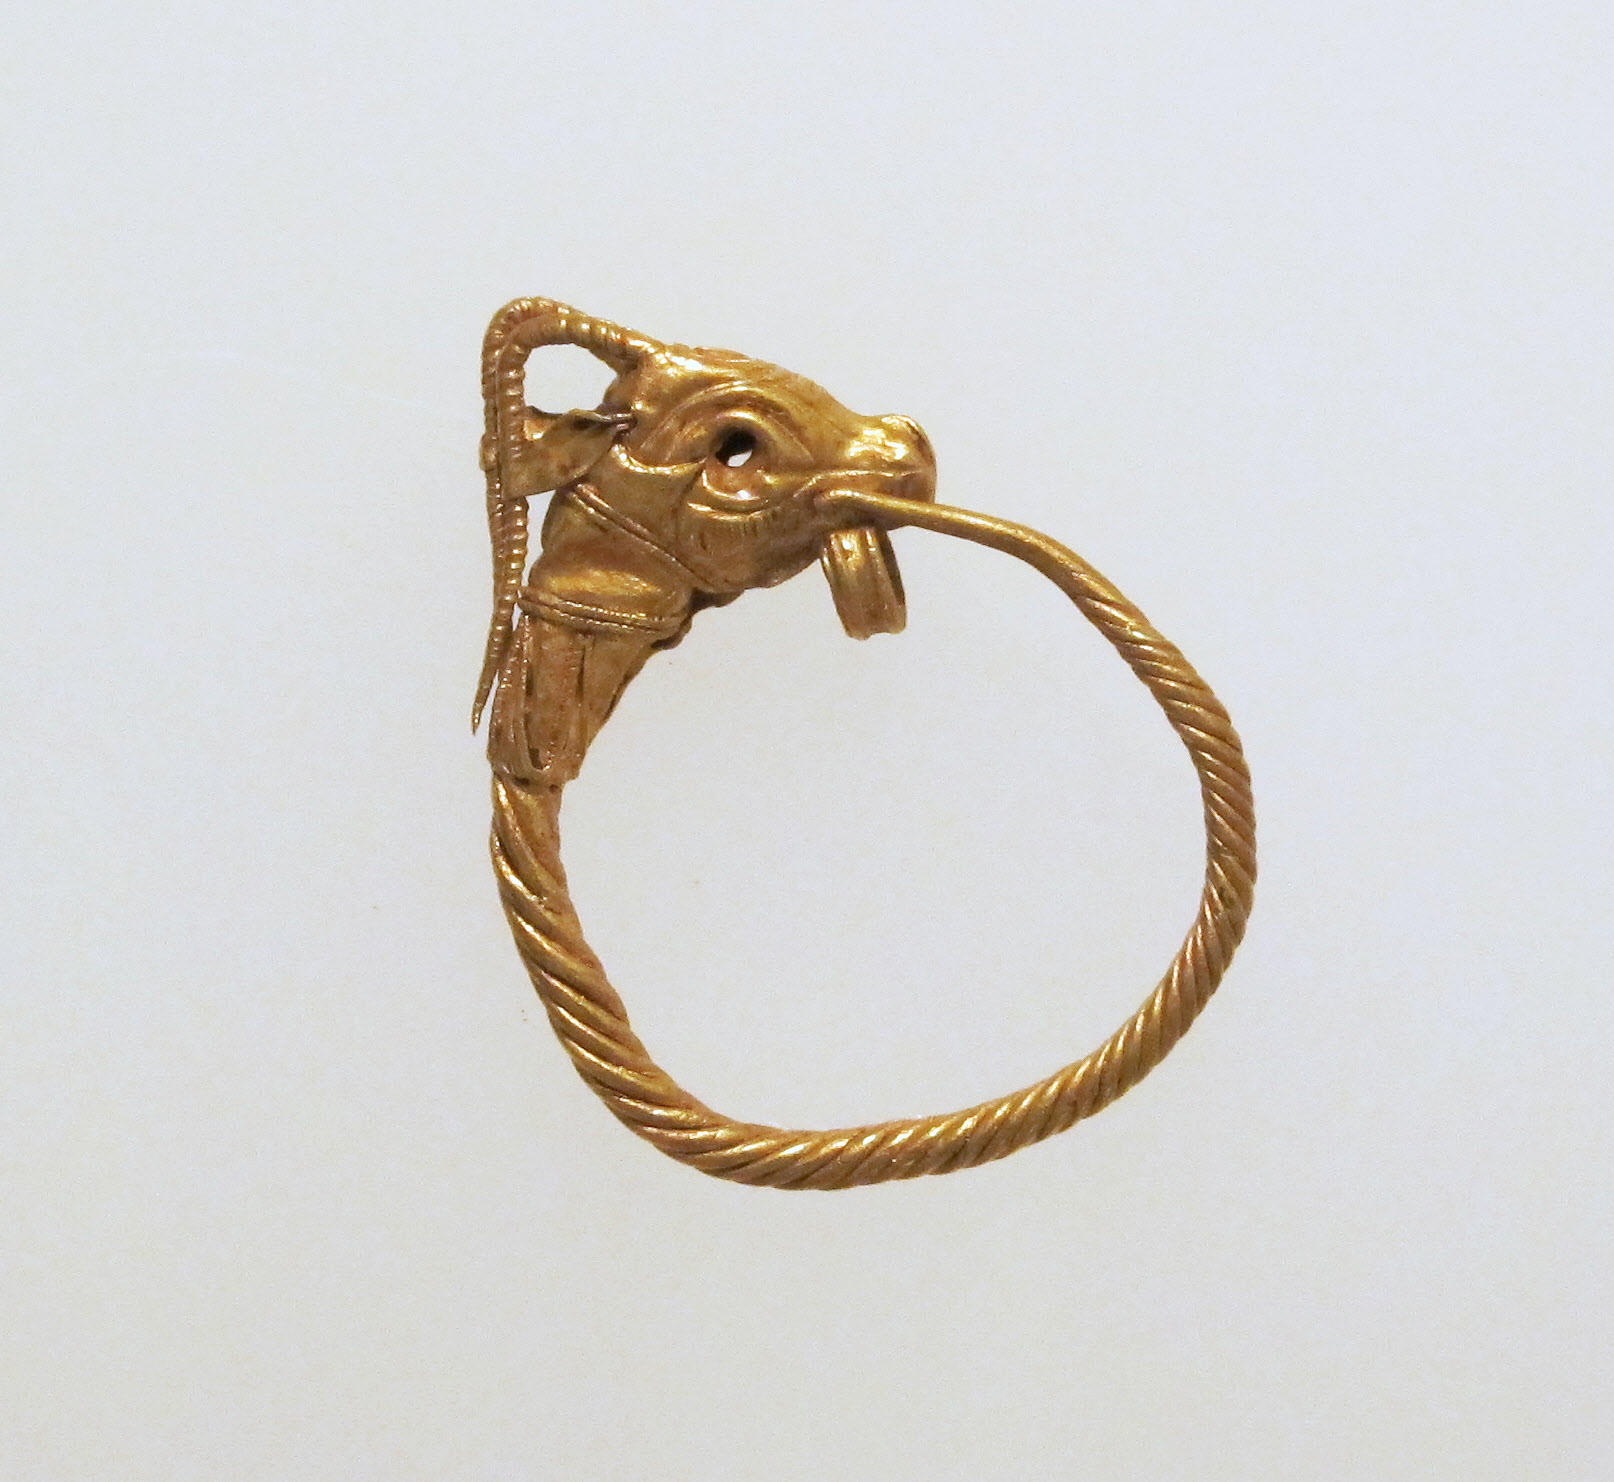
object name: earring with head of goat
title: Gold earring with head of a goat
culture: greek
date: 400-201 BCE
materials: gold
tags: goats